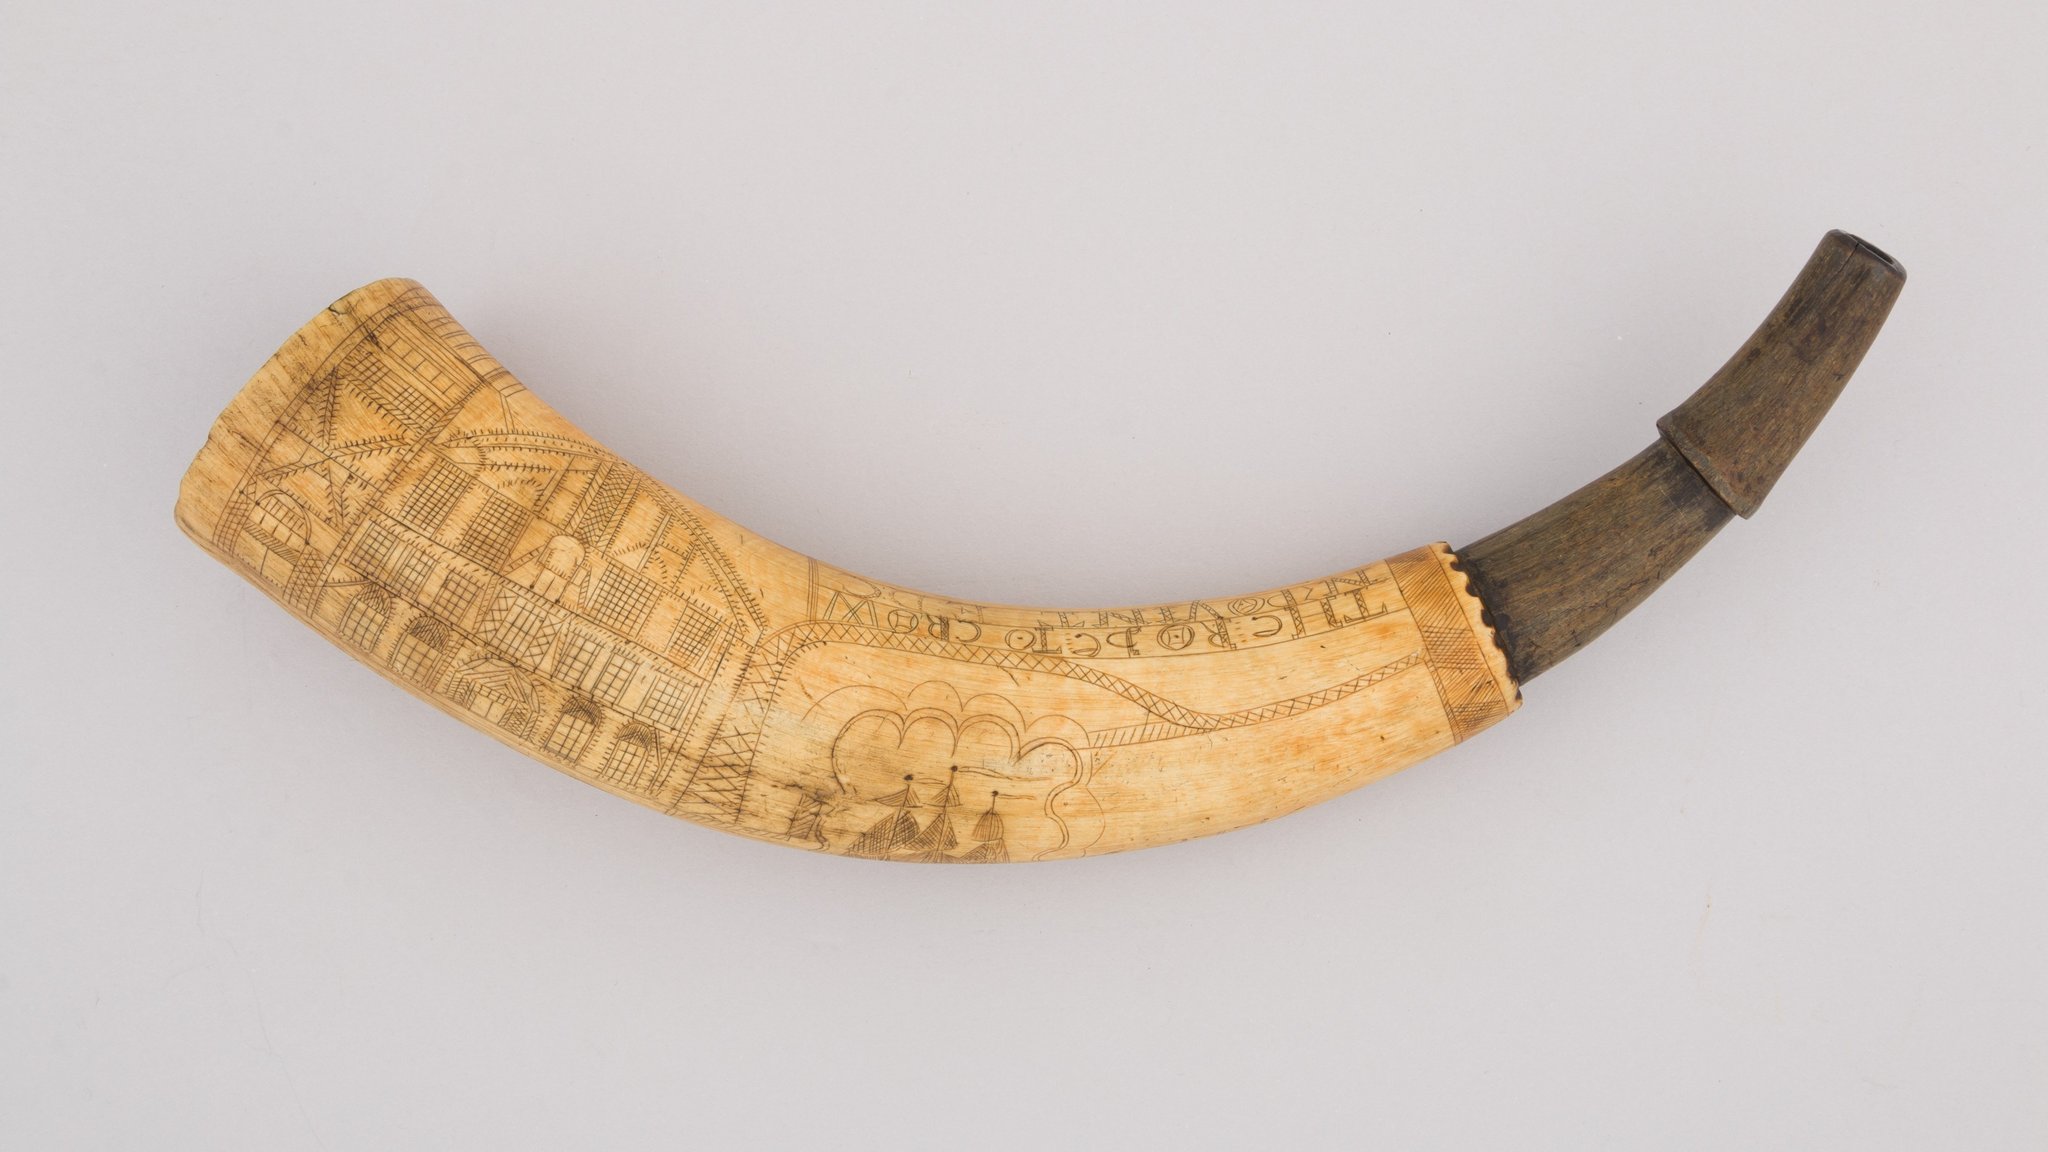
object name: powder horn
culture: colonial american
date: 1776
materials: brass, horn, wood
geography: united states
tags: ships